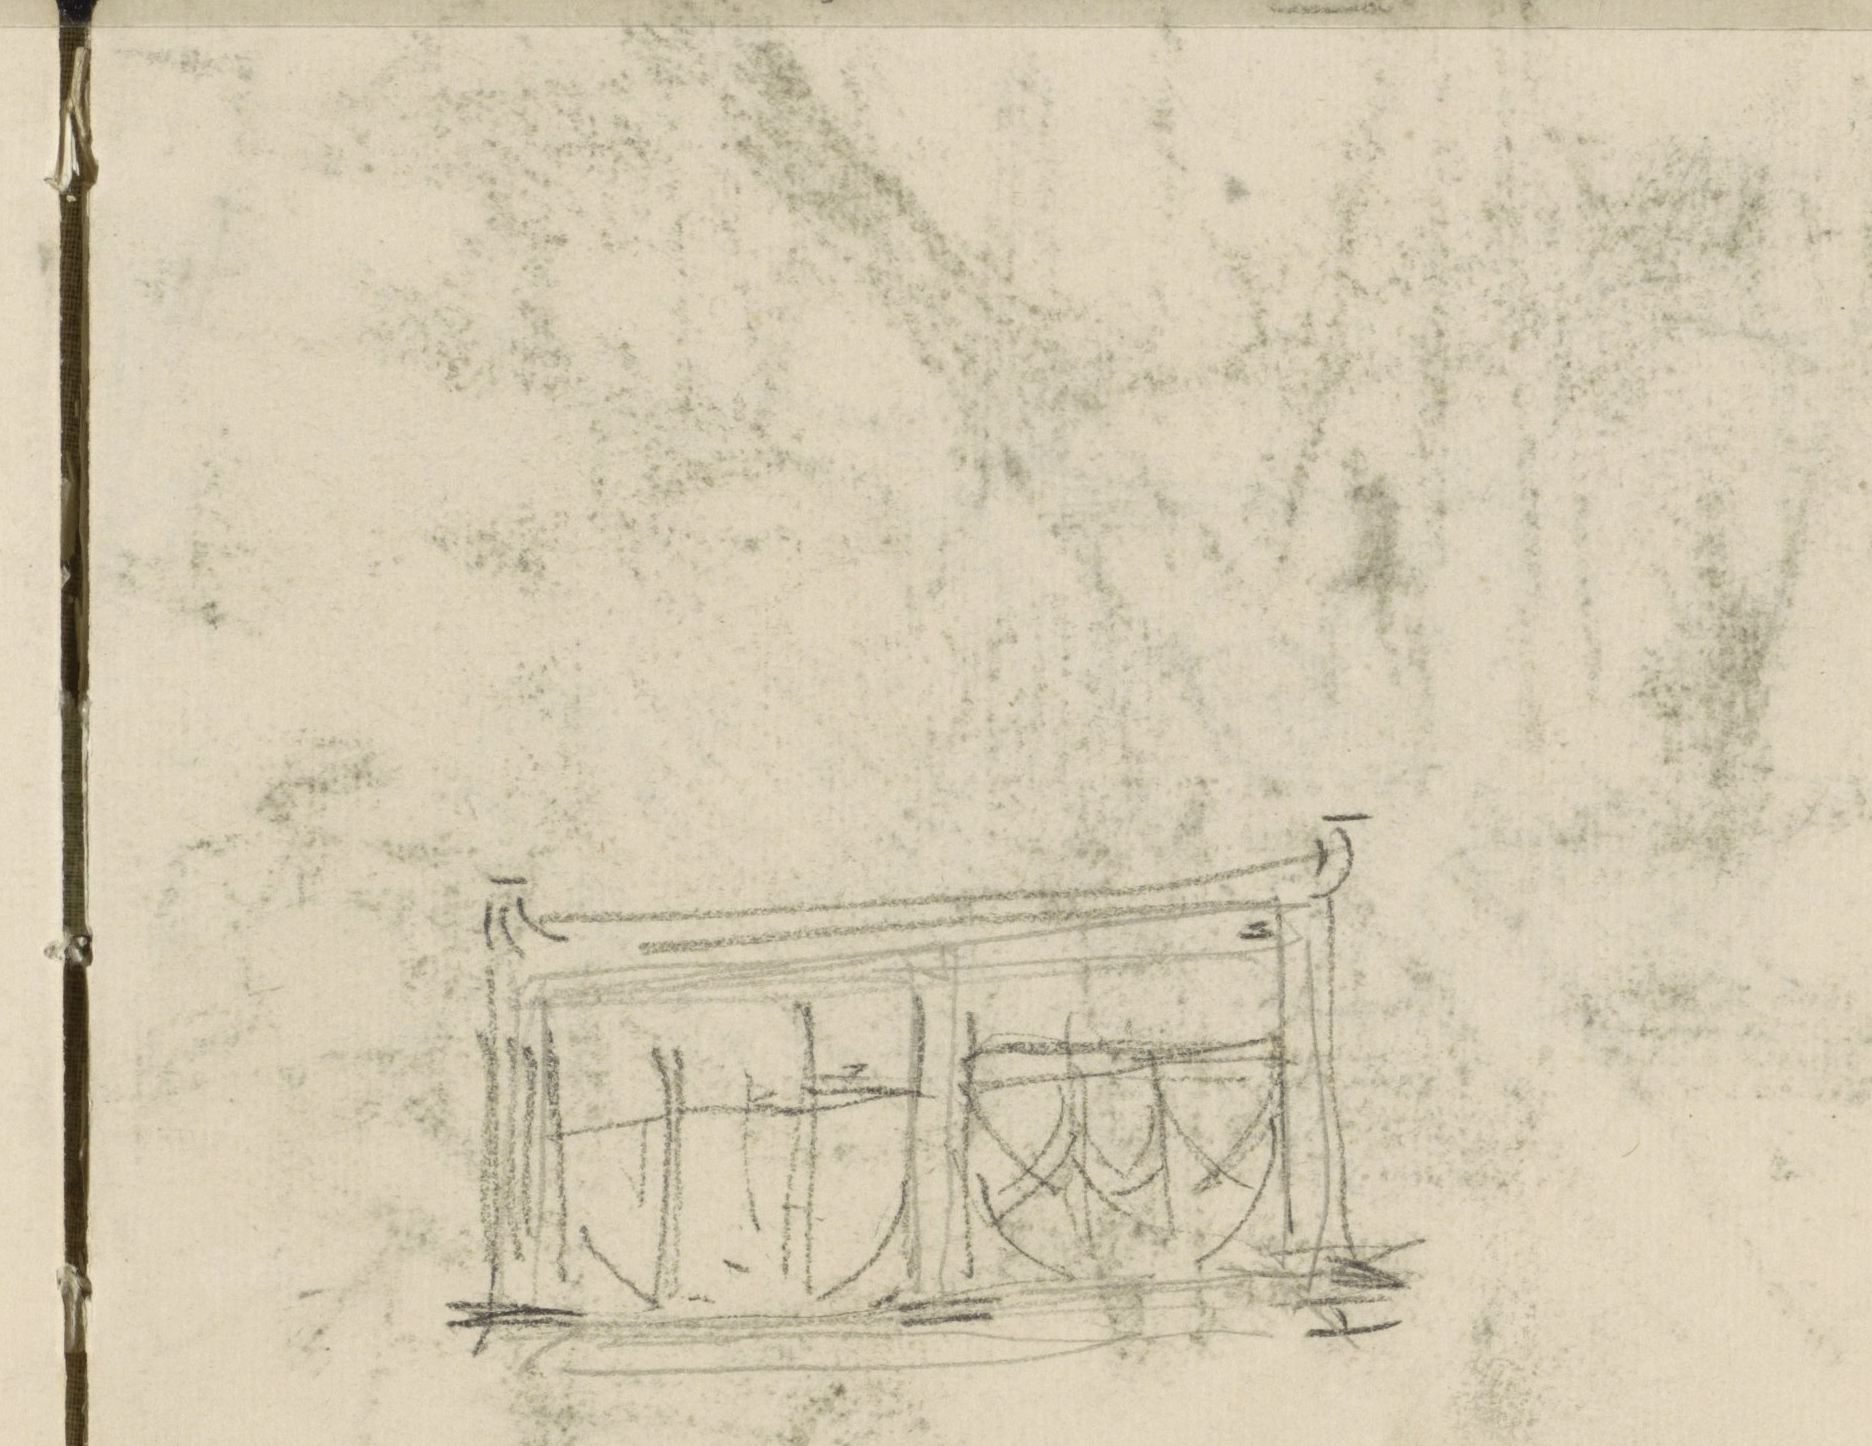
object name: sketchbook leaf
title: Studie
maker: george hendrik breitner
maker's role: draughtsman, painter, print maker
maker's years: 1857-1923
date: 1893-1899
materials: chalk, paper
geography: amsterdam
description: Pagina 46 uit een schetsboek met 28 bladen.